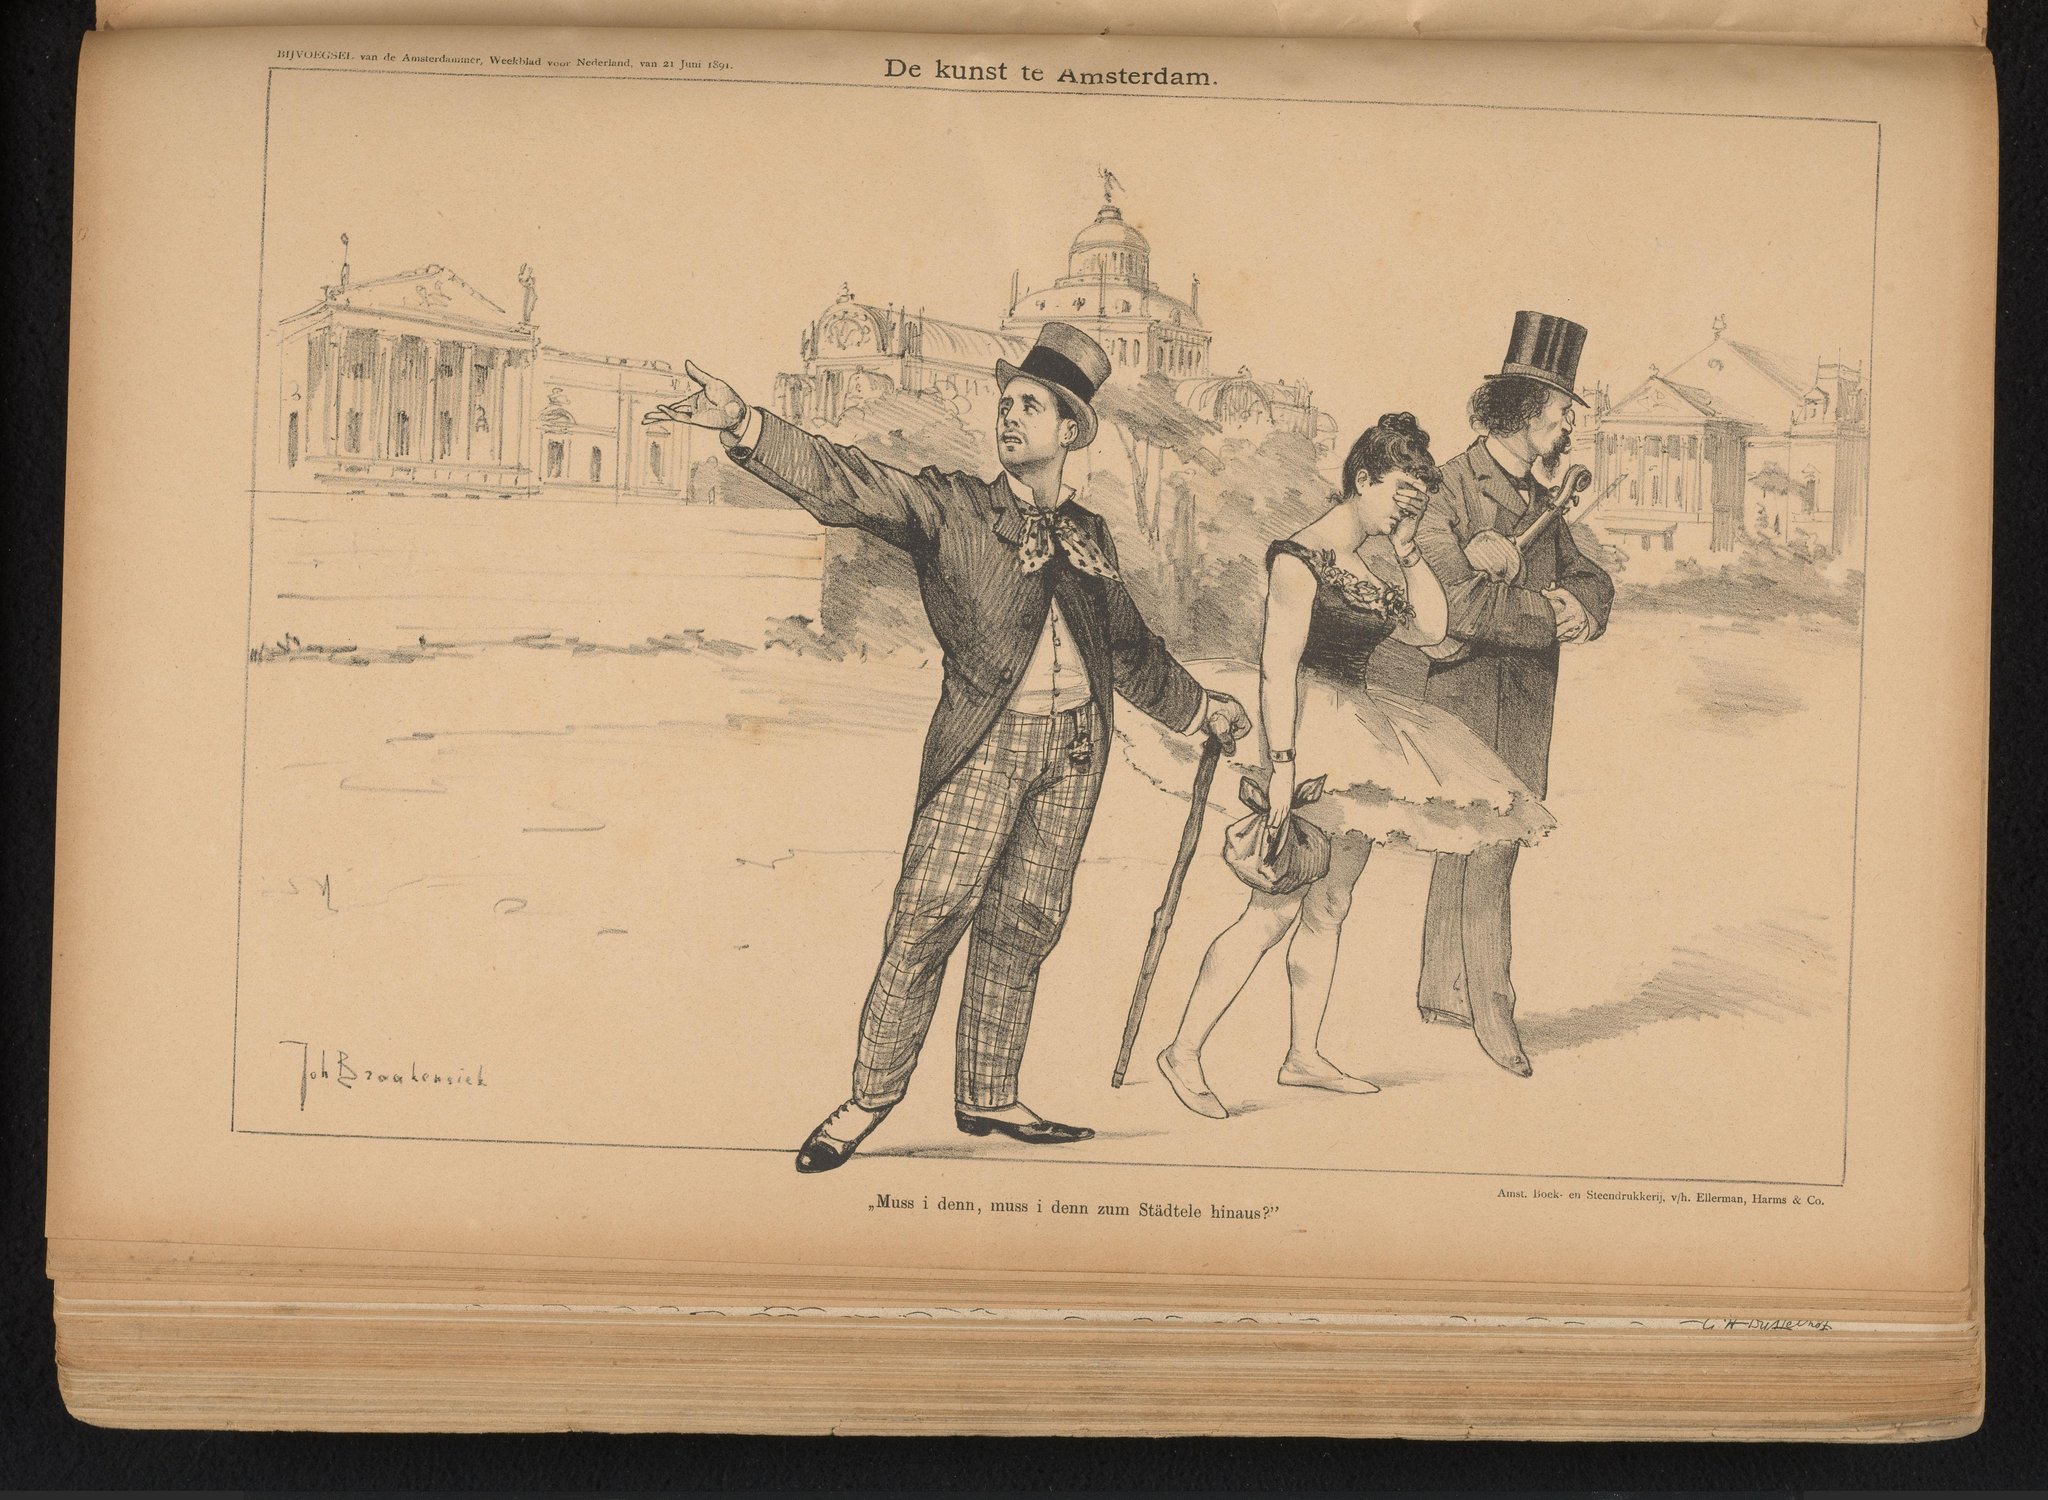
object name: cartoon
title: De kunst te Amsterdam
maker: johan braakensiek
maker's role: draughtsman, print maker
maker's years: 1858-1940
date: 1891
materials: paper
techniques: lithograph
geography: netherlands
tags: musician, female dancer, actor (on the stage), political caricatures and satires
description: Drie artiesten, een toneelspeler, een balletdanseres en een violist, betreuren dat ze Amsterdam moeten verlaten. Op de achtergrond het Paleis voor Volksvlijt, het Concertgebouw en het oude schouwburg op het Leidseplein. In het onderschrift de eerste regels van het liedje 'Muss i denn'.